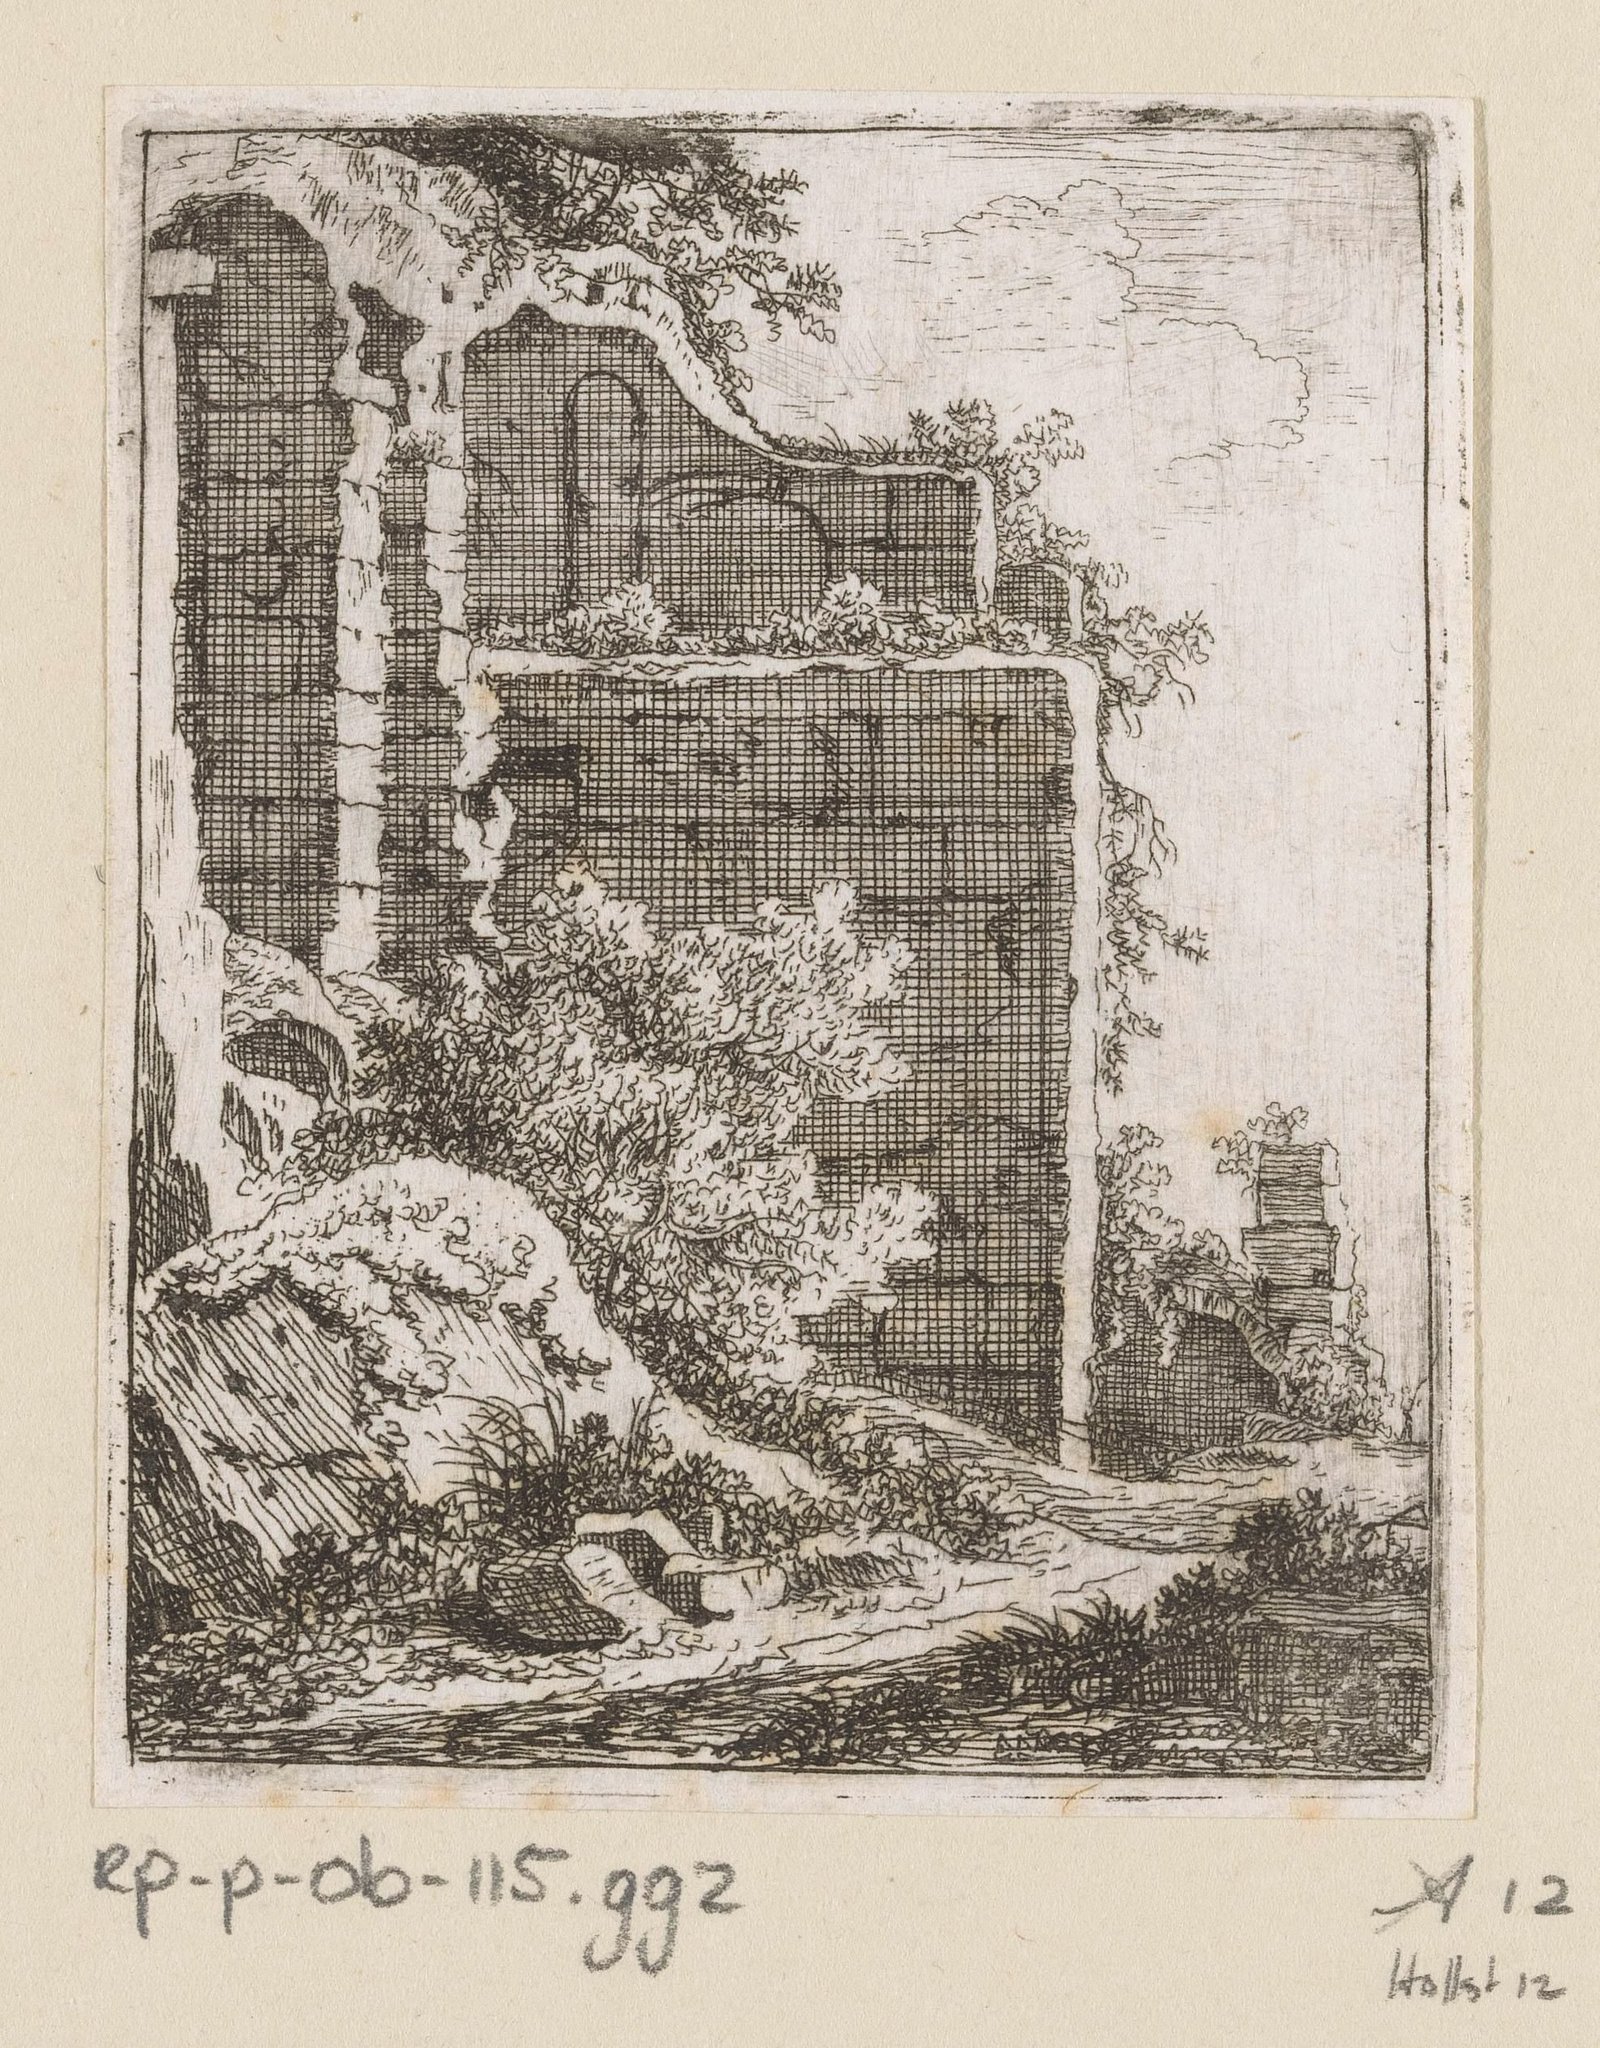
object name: print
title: Romeinse ruïnes en monumenten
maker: johann franz ermels (der ältere)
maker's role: draughtsman, print maker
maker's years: 1641-1693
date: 1651-1693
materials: paper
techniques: etching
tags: fence, wall, paling, landscape with ruins, rome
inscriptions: collector's mark: Lugt 240